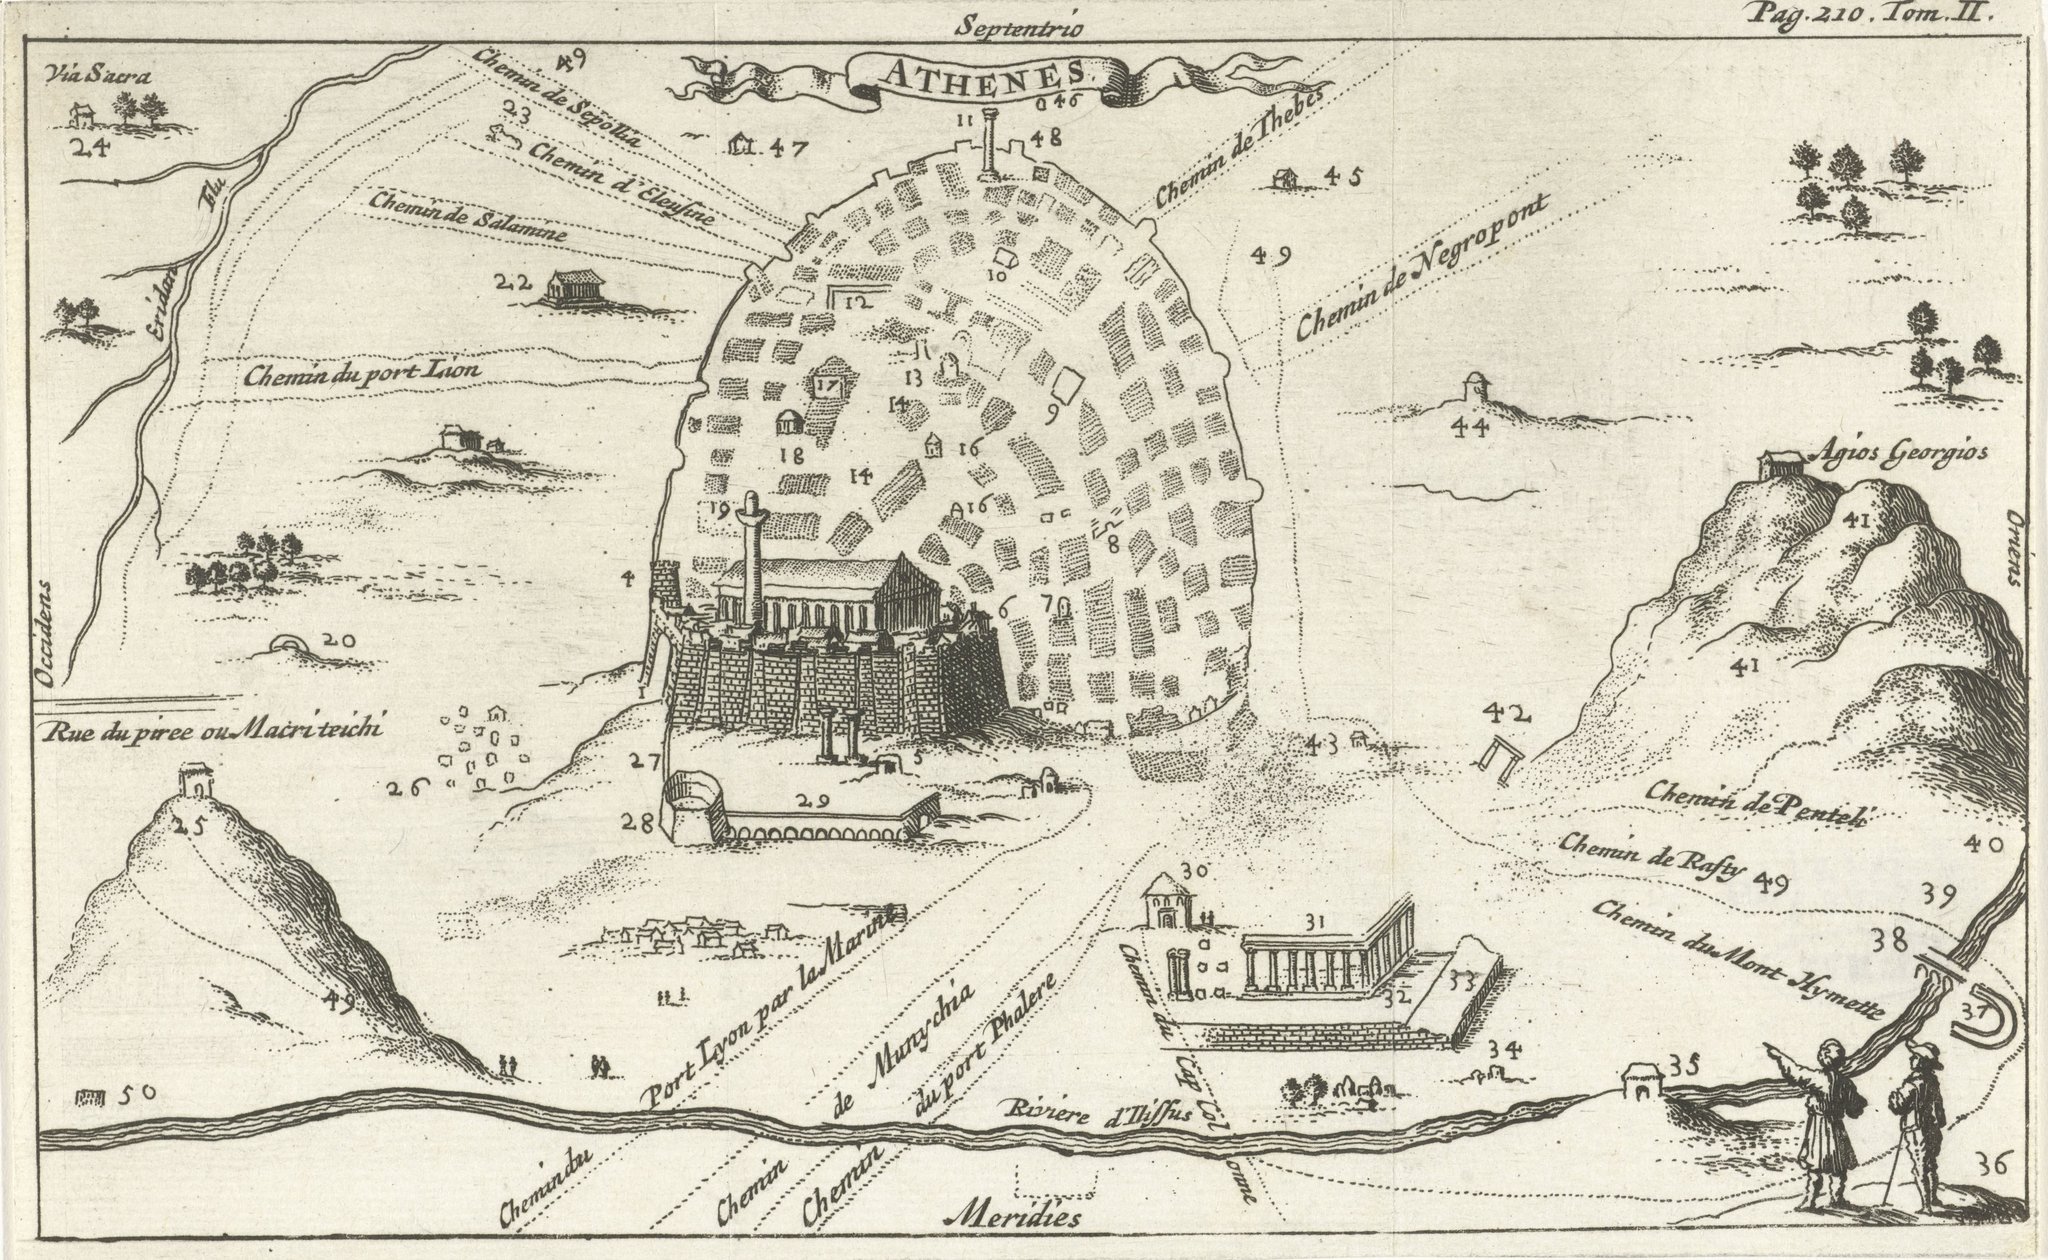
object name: print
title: Athenes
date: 1679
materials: paper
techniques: etching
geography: amsterdam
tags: maps of cities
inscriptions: collector's mark: Lugt 2228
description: Illustratie opgenomen in: Spon, Jacob. Voyage d'Italie, de Dalmatie, de Grece, et du Levant, 2 delen, dl. II, p. 210. Amsterdam: Hendrick en Dirk Boom, 1679.